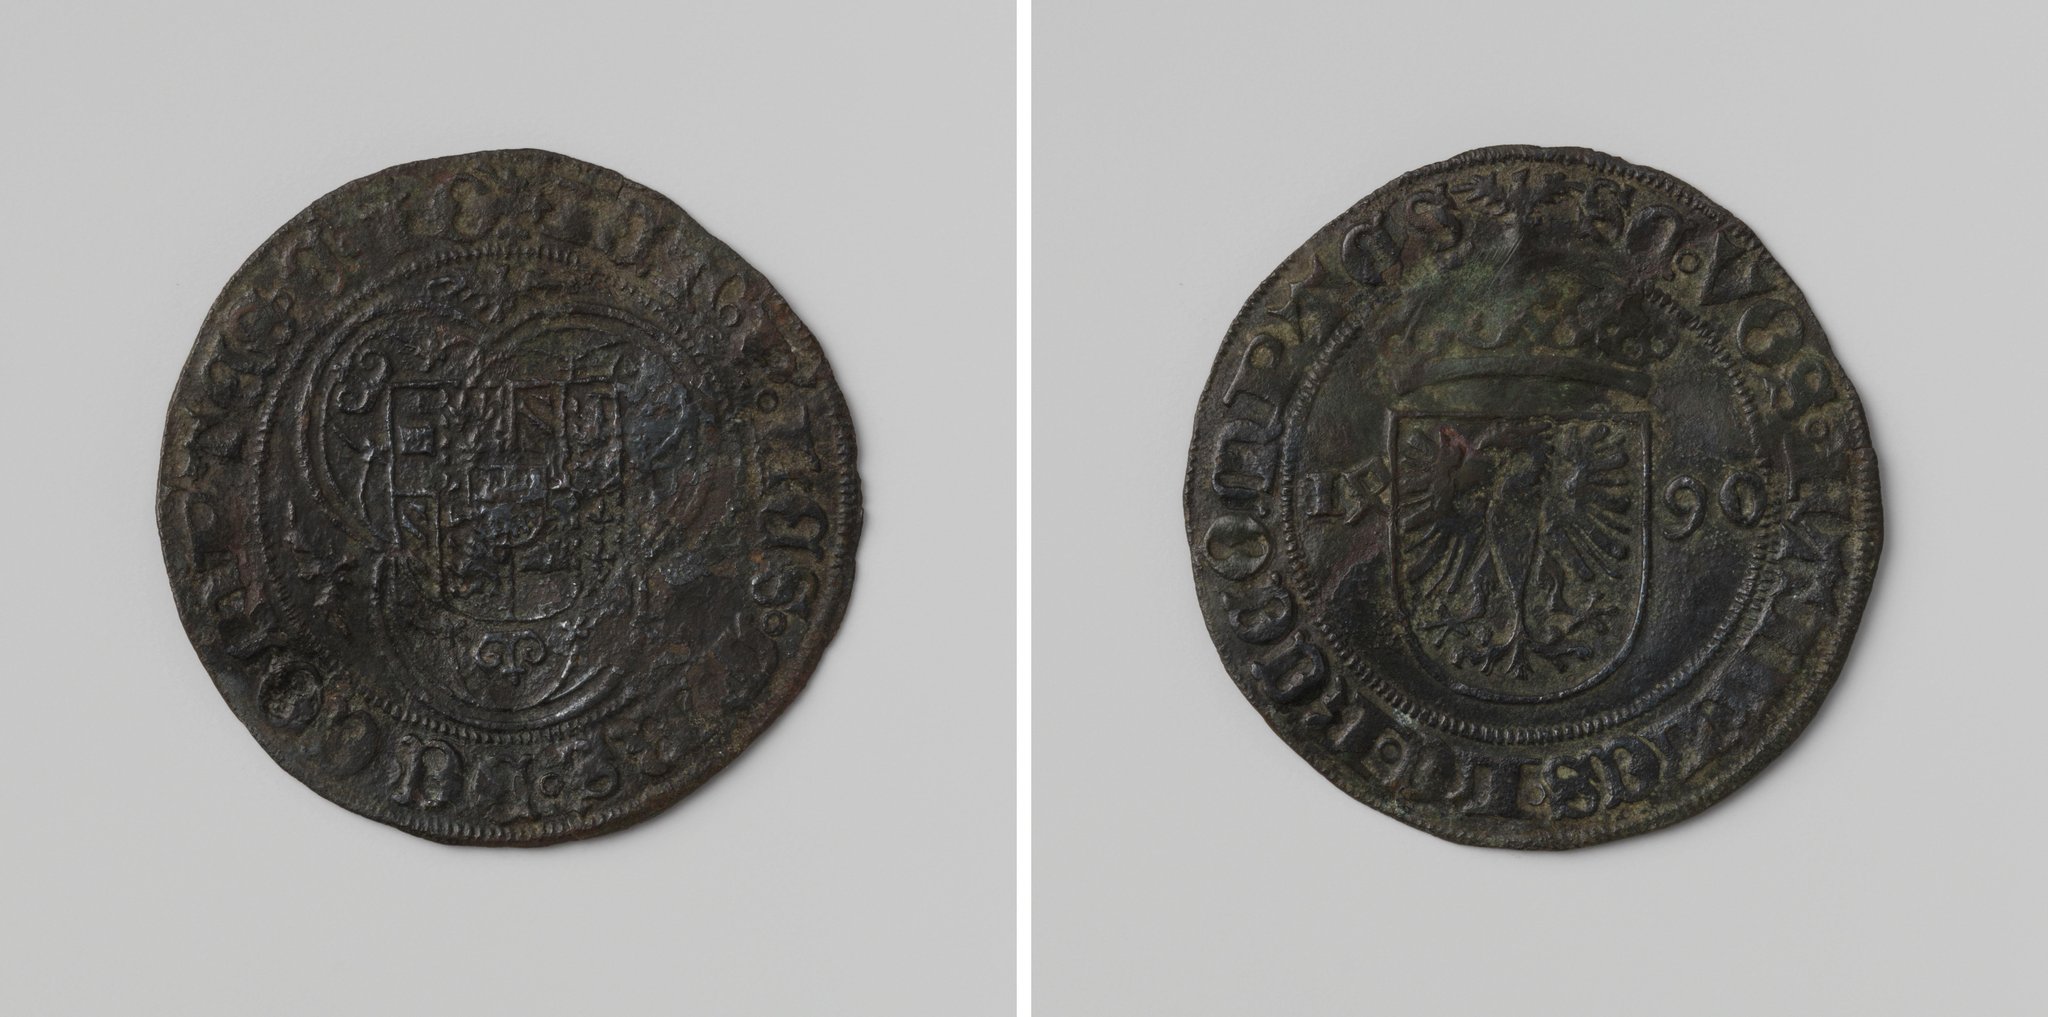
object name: jeton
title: Filips de Schone, hertog van Bourgondie, rekenpenning van de rekenkamer van Holland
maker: Anonymous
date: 1490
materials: copper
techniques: striking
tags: maximilian i (holy roman emperor), bruges, filips de schone (hertog van bourgondië), holland